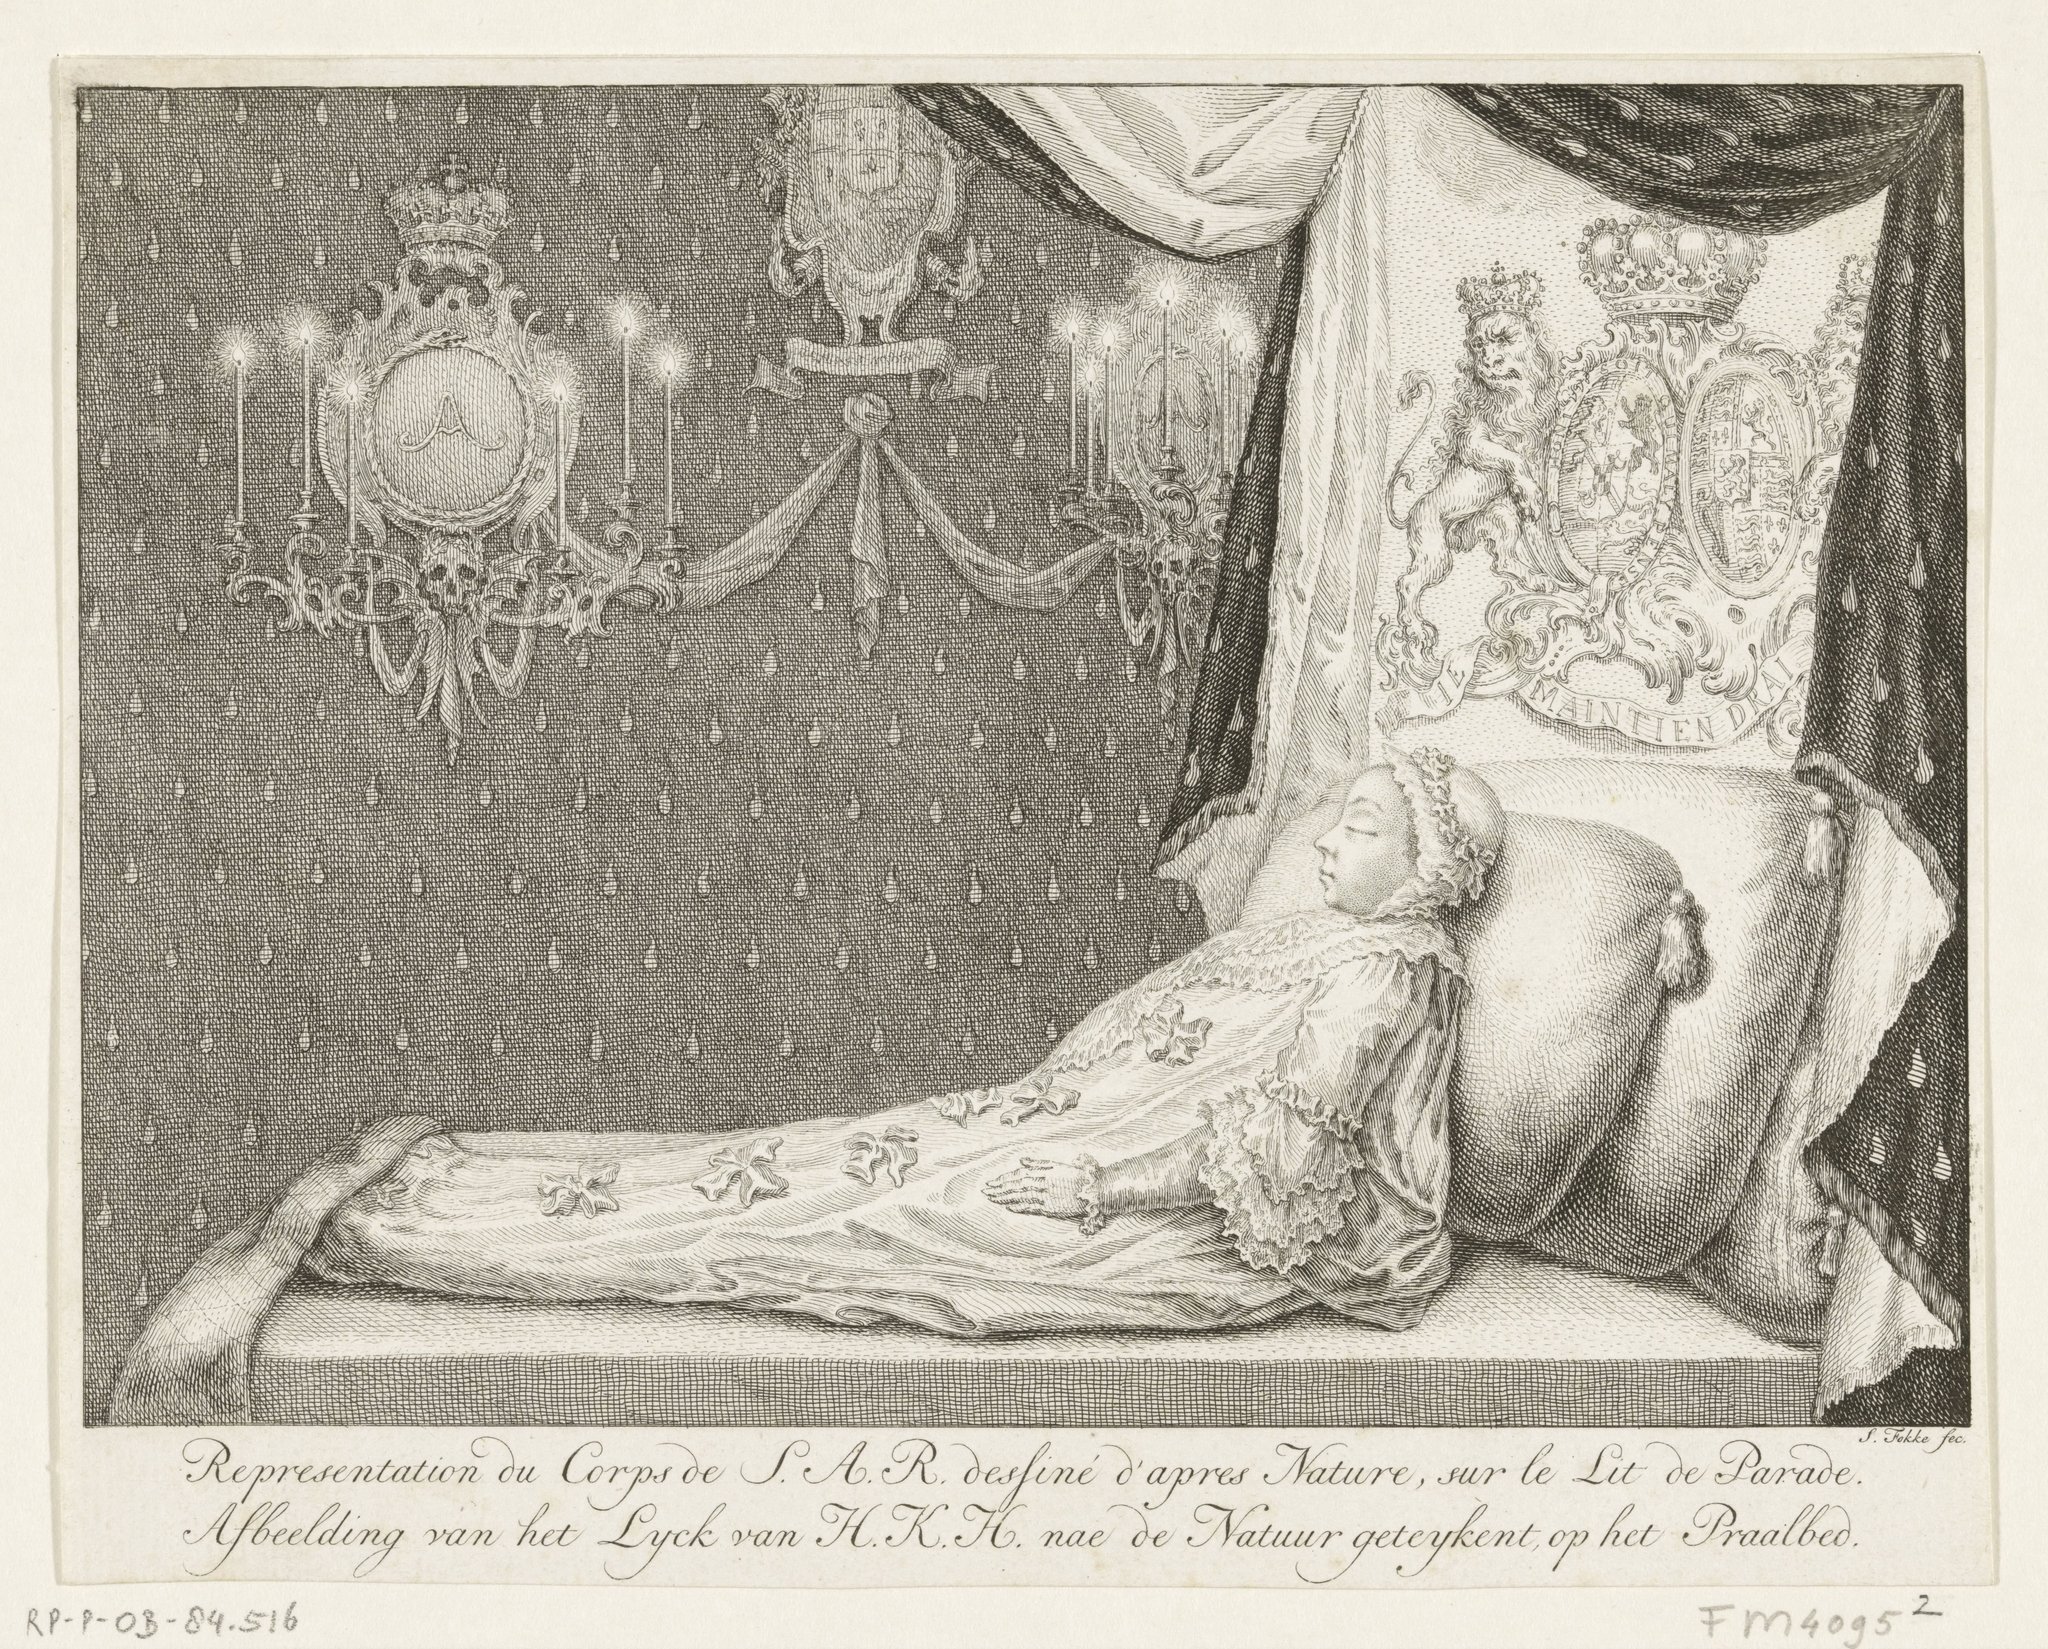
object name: print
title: Praalbed van prinses Anna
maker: simon fokke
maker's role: draughtsman, print maker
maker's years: 1712-1784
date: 1759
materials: paper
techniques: engraving, etching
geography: northern netherlands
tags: the hague, anna van hannover, lying in state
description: Het opgebaarde lijk van de prinses op het praalbed. Onderdeel van een serie van vier platen van het praalbed waarop de op 12 januari 1759 overleden prinses Anna van Hannover gedurende enkele dagen in februari opgebaard heeft gelegen.